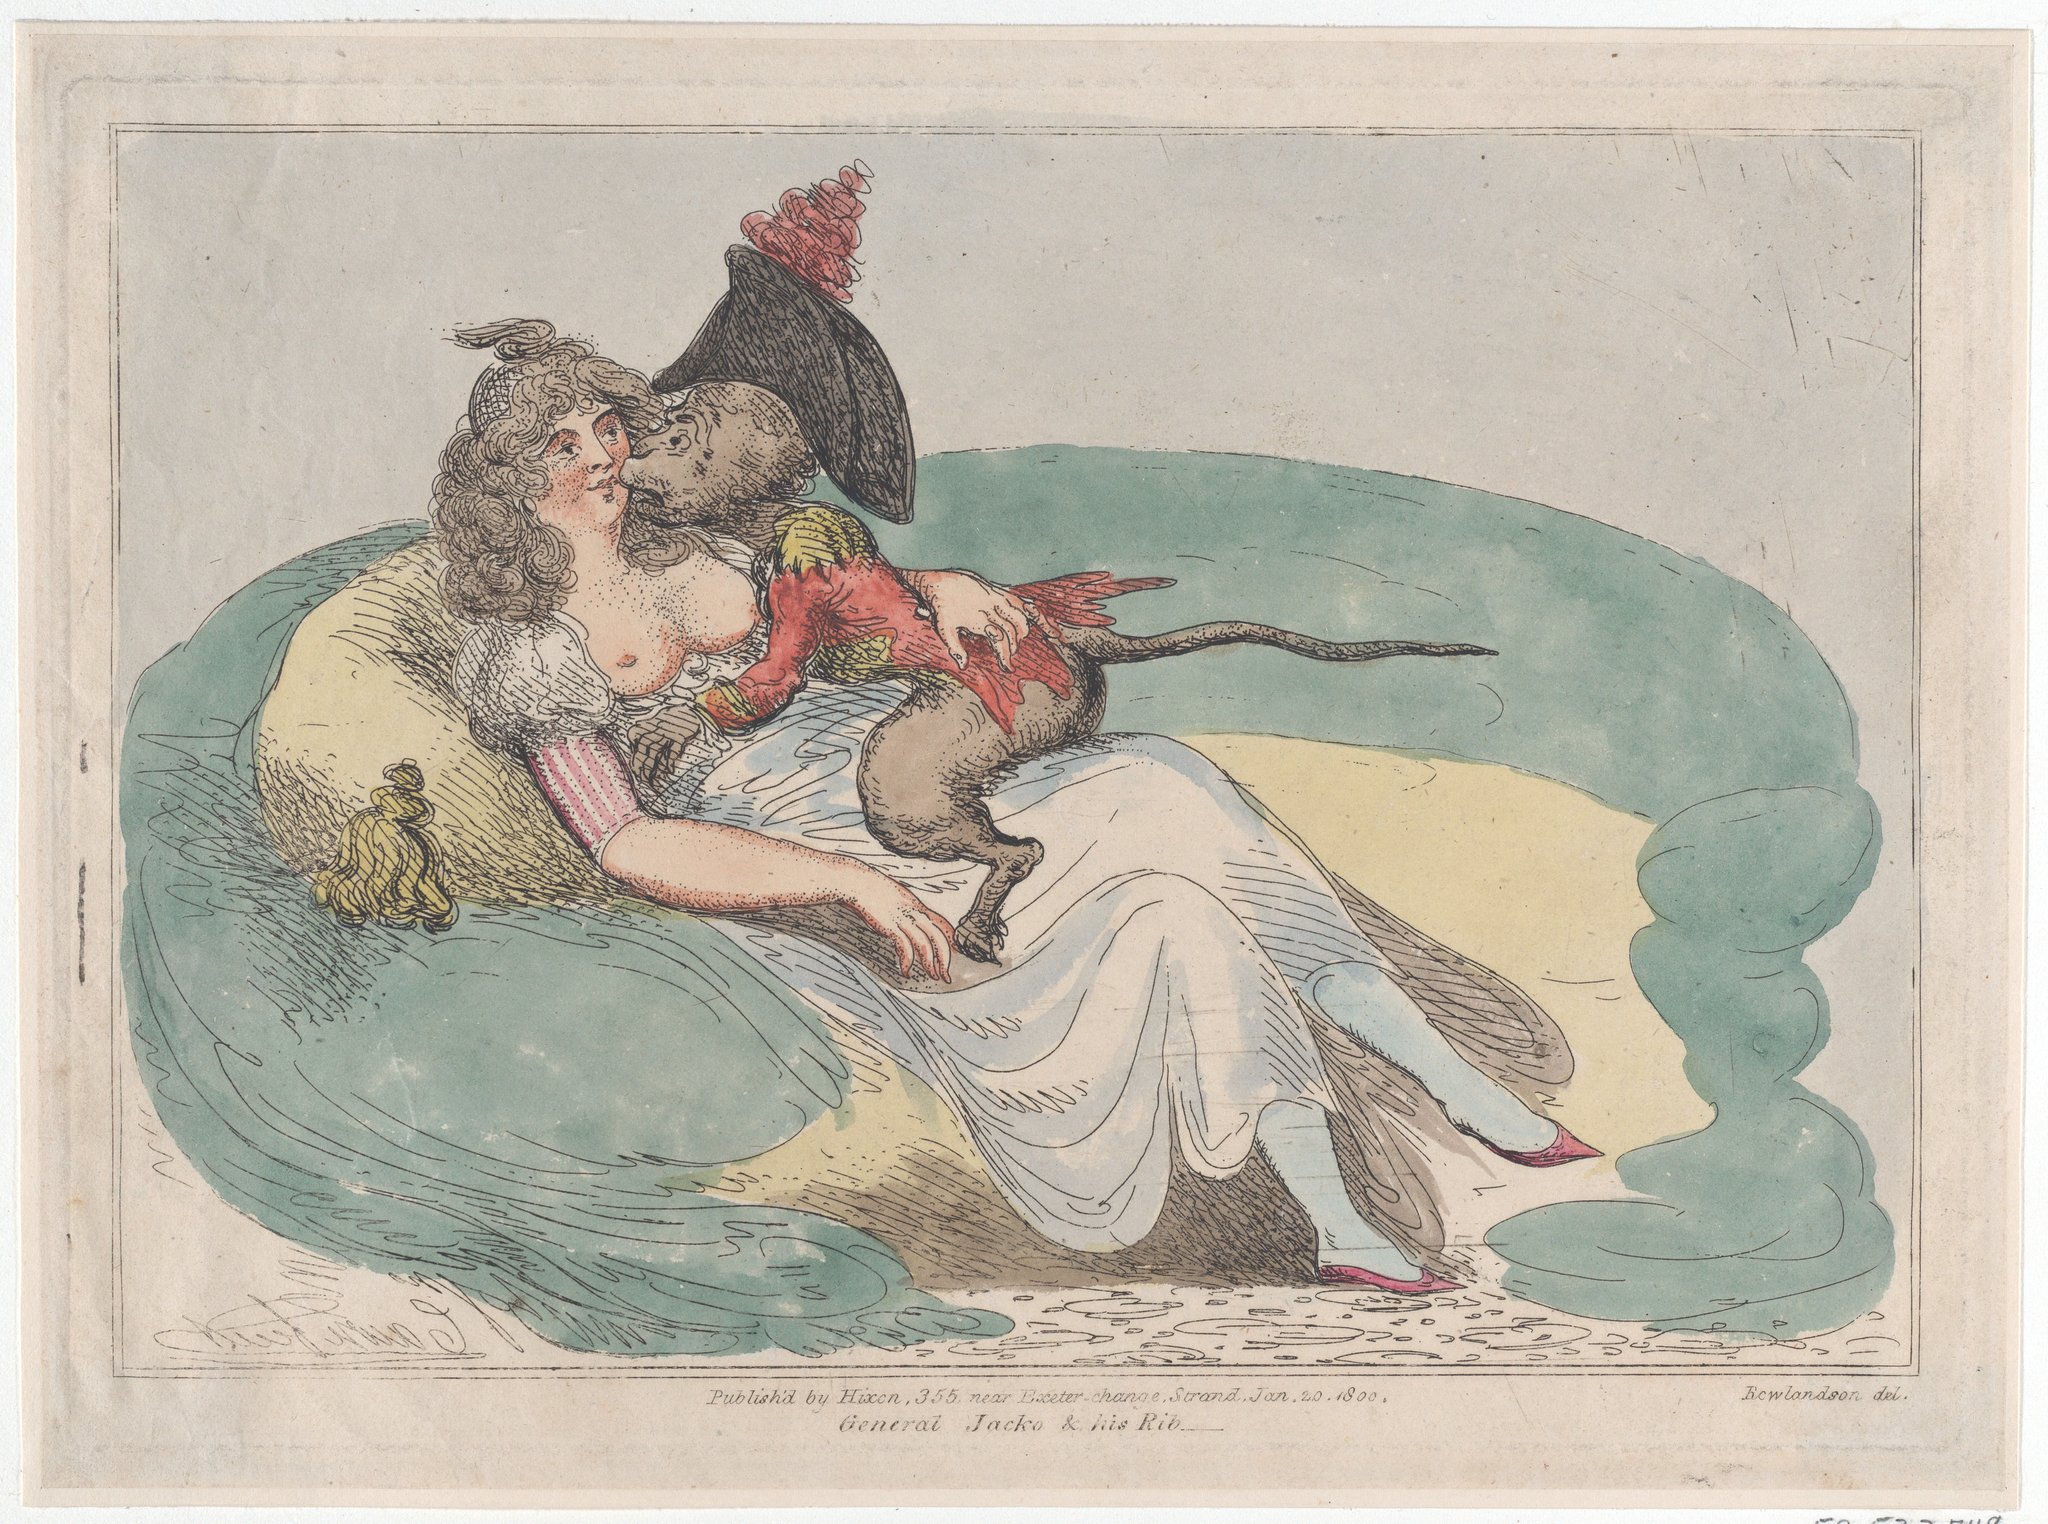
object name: print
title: General Jacko & his Rib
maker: john cawse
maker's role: etcher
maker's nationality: british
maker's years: 1779-1862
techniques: etching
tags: satire,women,monkeys